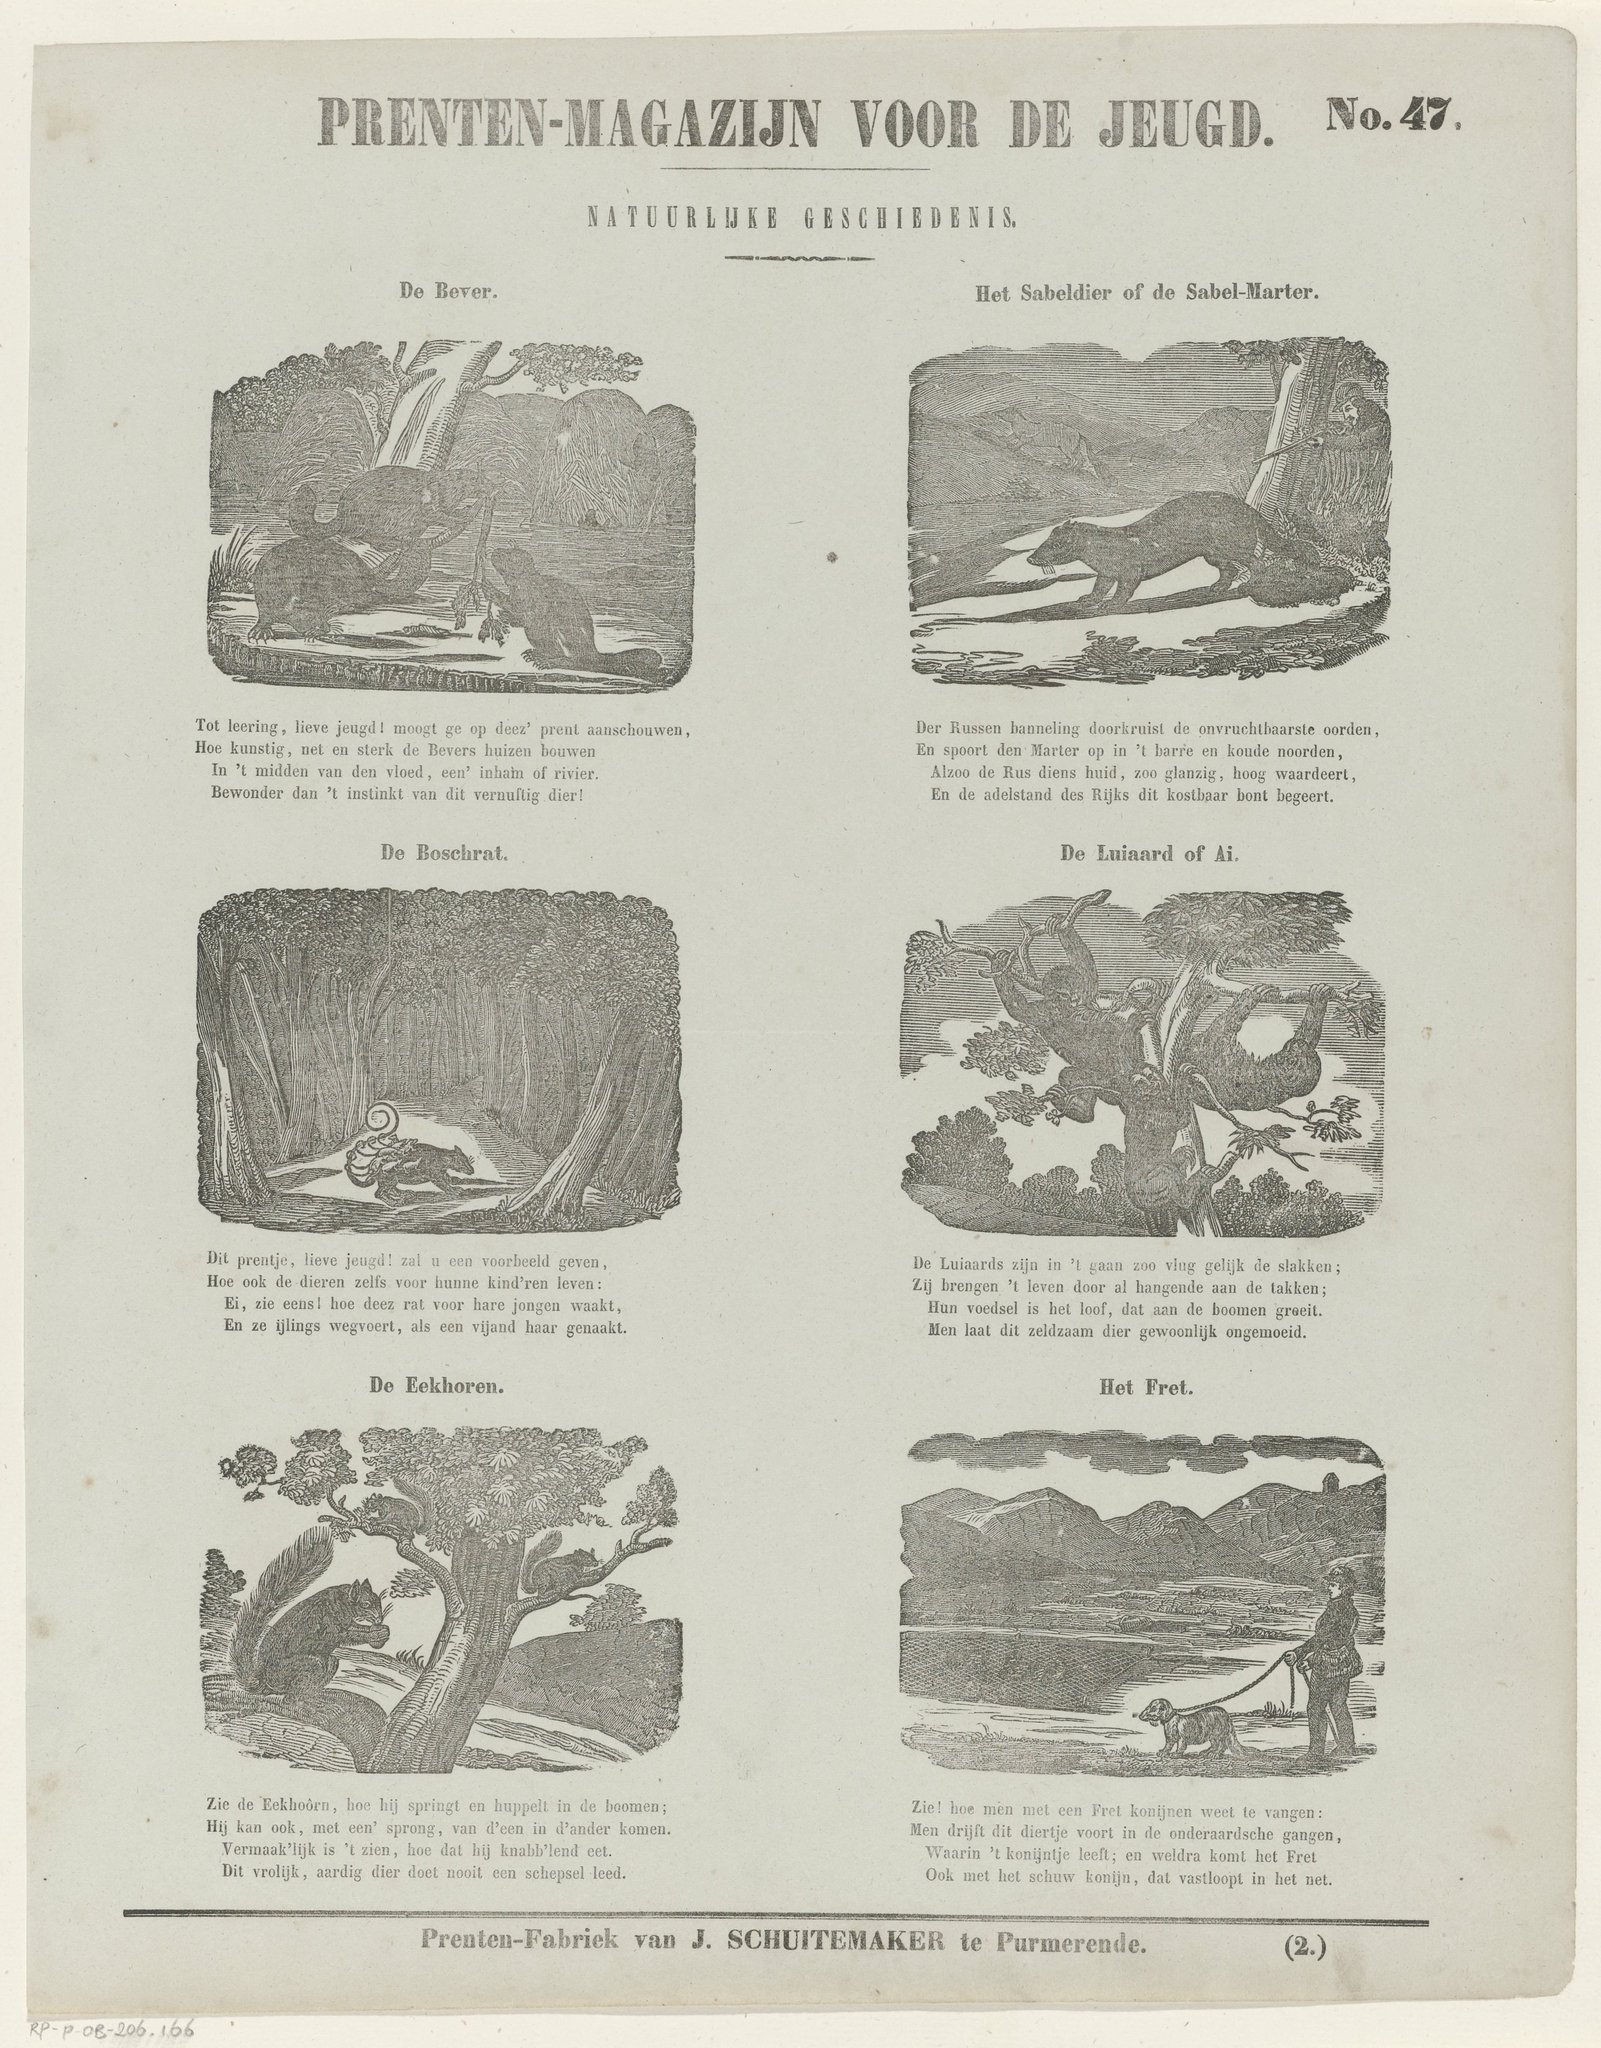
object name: popular print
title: Prenten-magazijn voor de jeugd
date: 1850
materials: paper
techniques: letterpress printing, engraving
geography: purmerend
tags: animals, rodents: rat, beasts of prey, predatory animals: ferret, rodents: squirrel, rodents: beaver, beasts of prey, predatory animals: marten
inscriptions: collector's mark: Lugt 2760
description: Na voltooiing van de acht jaargangen van de reeks 'Prenten-magazijn voor de jeugd' in 1850 heeft Jan Schuitemaker al deze prenten heruitgegeven en omgenummerd als nr. 1 t/m 192. De oorspronkelijke jaargang wordt telkens nog vermeld rechtsonder op de prent. Binnen de jaargangen zijn prenten van hetzelfde thema in clusters van vier achter elkaar gezet.